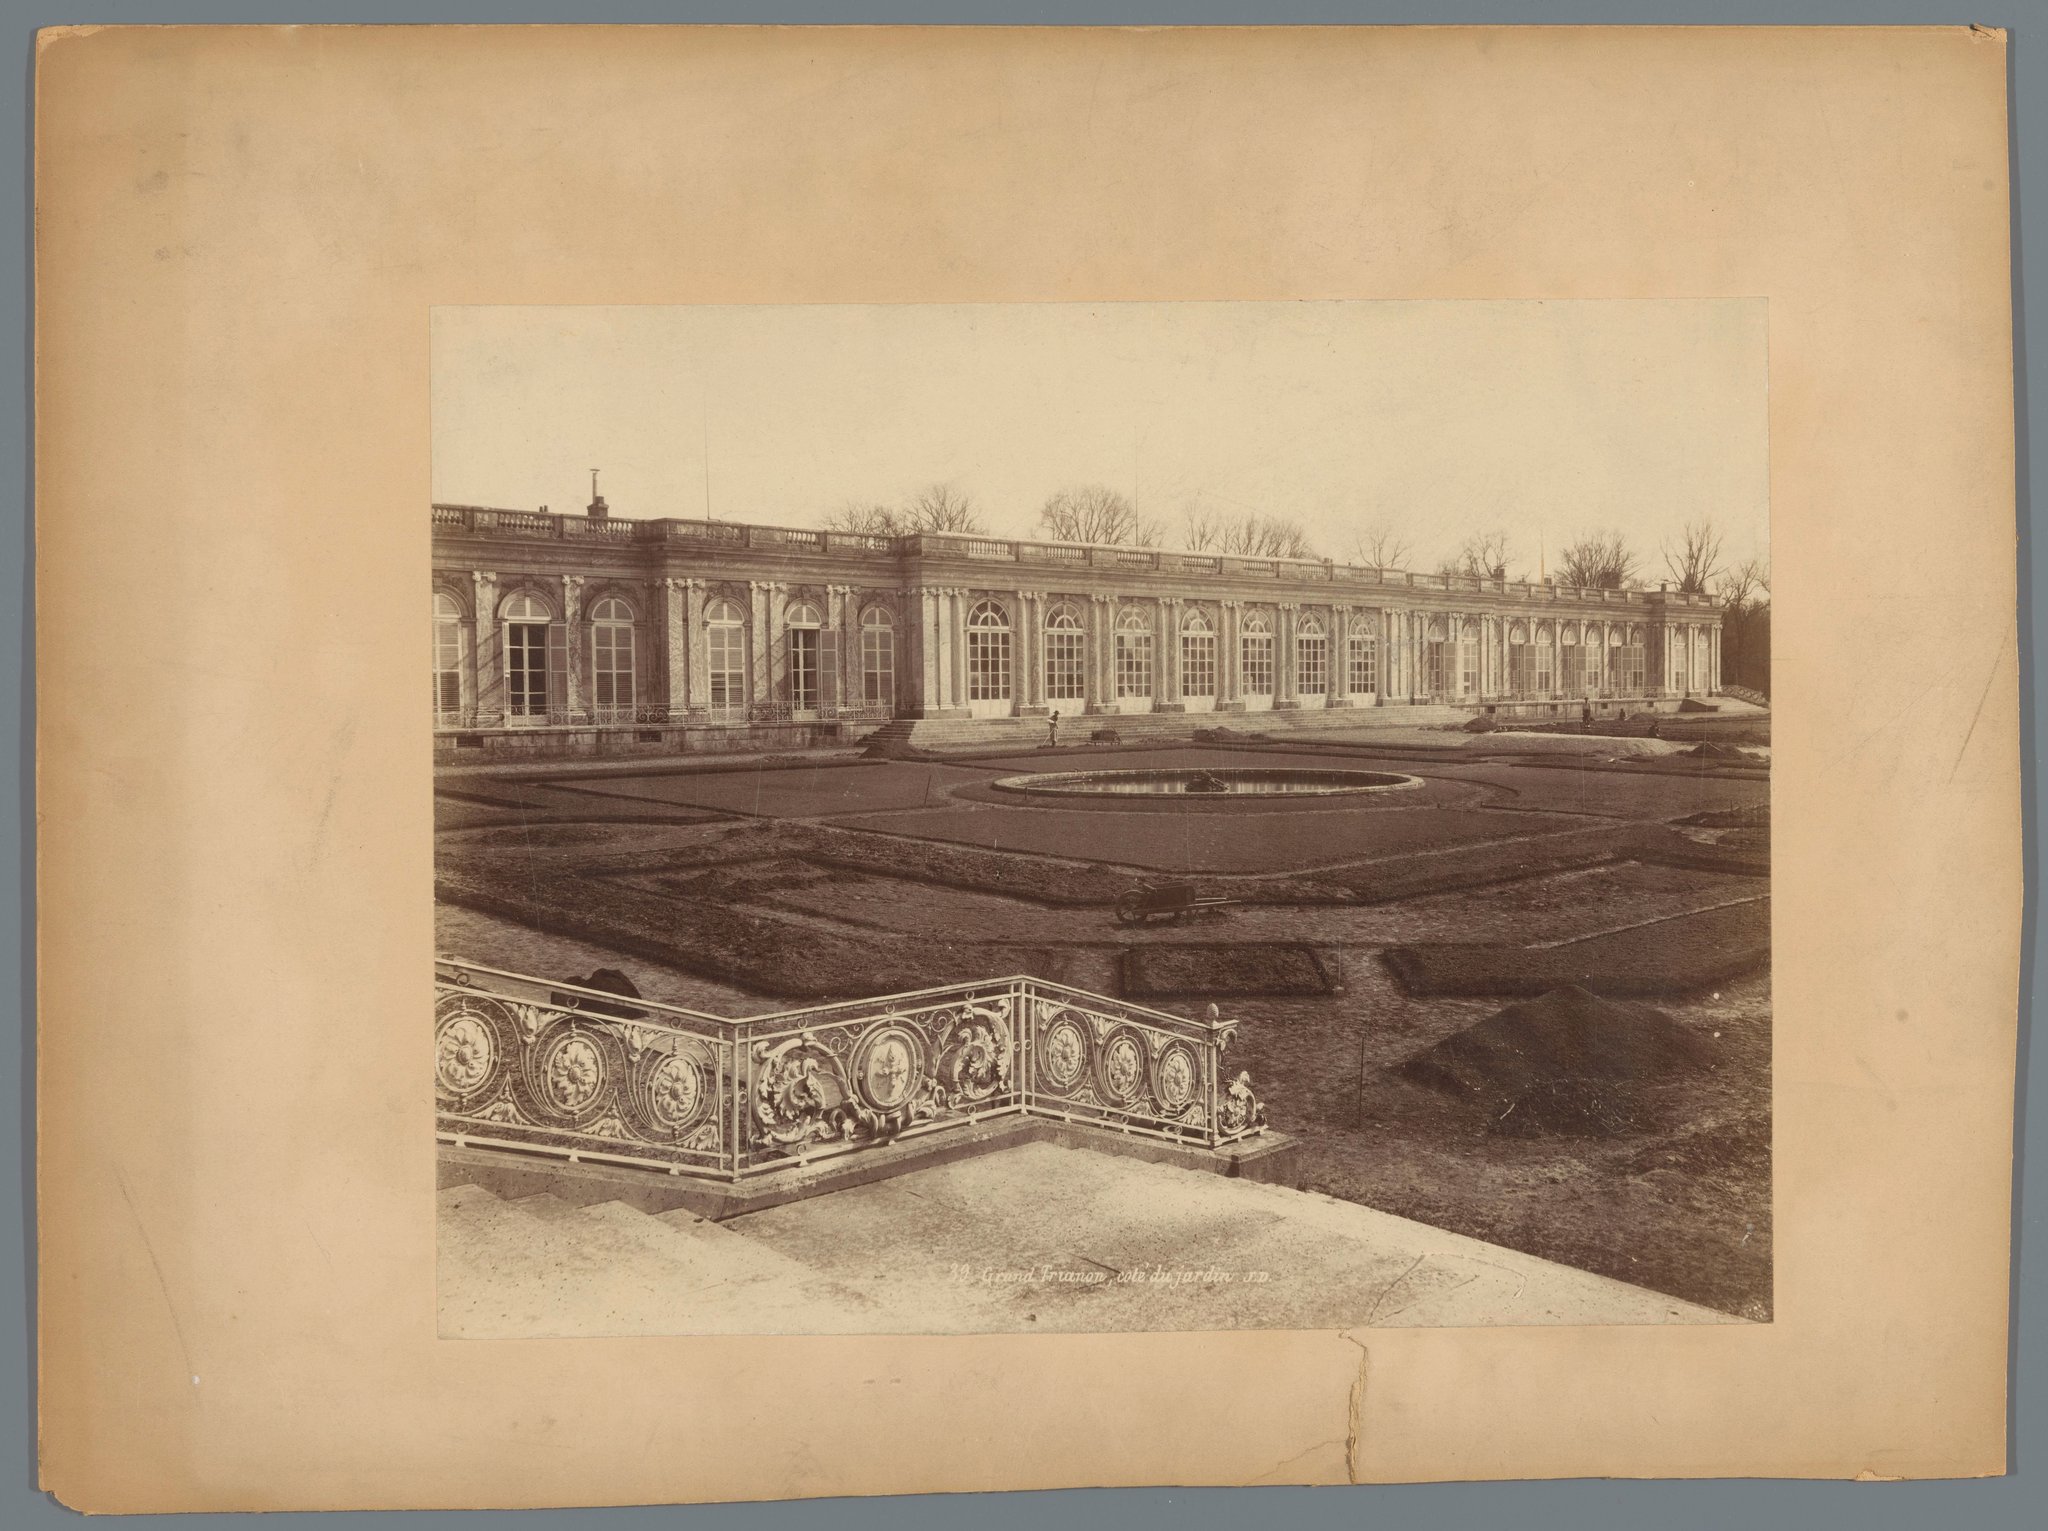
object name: photograph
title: Grand Trianon, coté du jardin. J.D.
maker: Anonymous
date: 1875-1900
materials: cardboard, photographic support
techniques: albumen print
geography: versailles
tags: column, pillar ~ architecture, garden, staircase, exterior ~ representation of a building, façade (of house or building)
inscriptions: collector's mark: Lugt 3937, number: ‘No. 39’